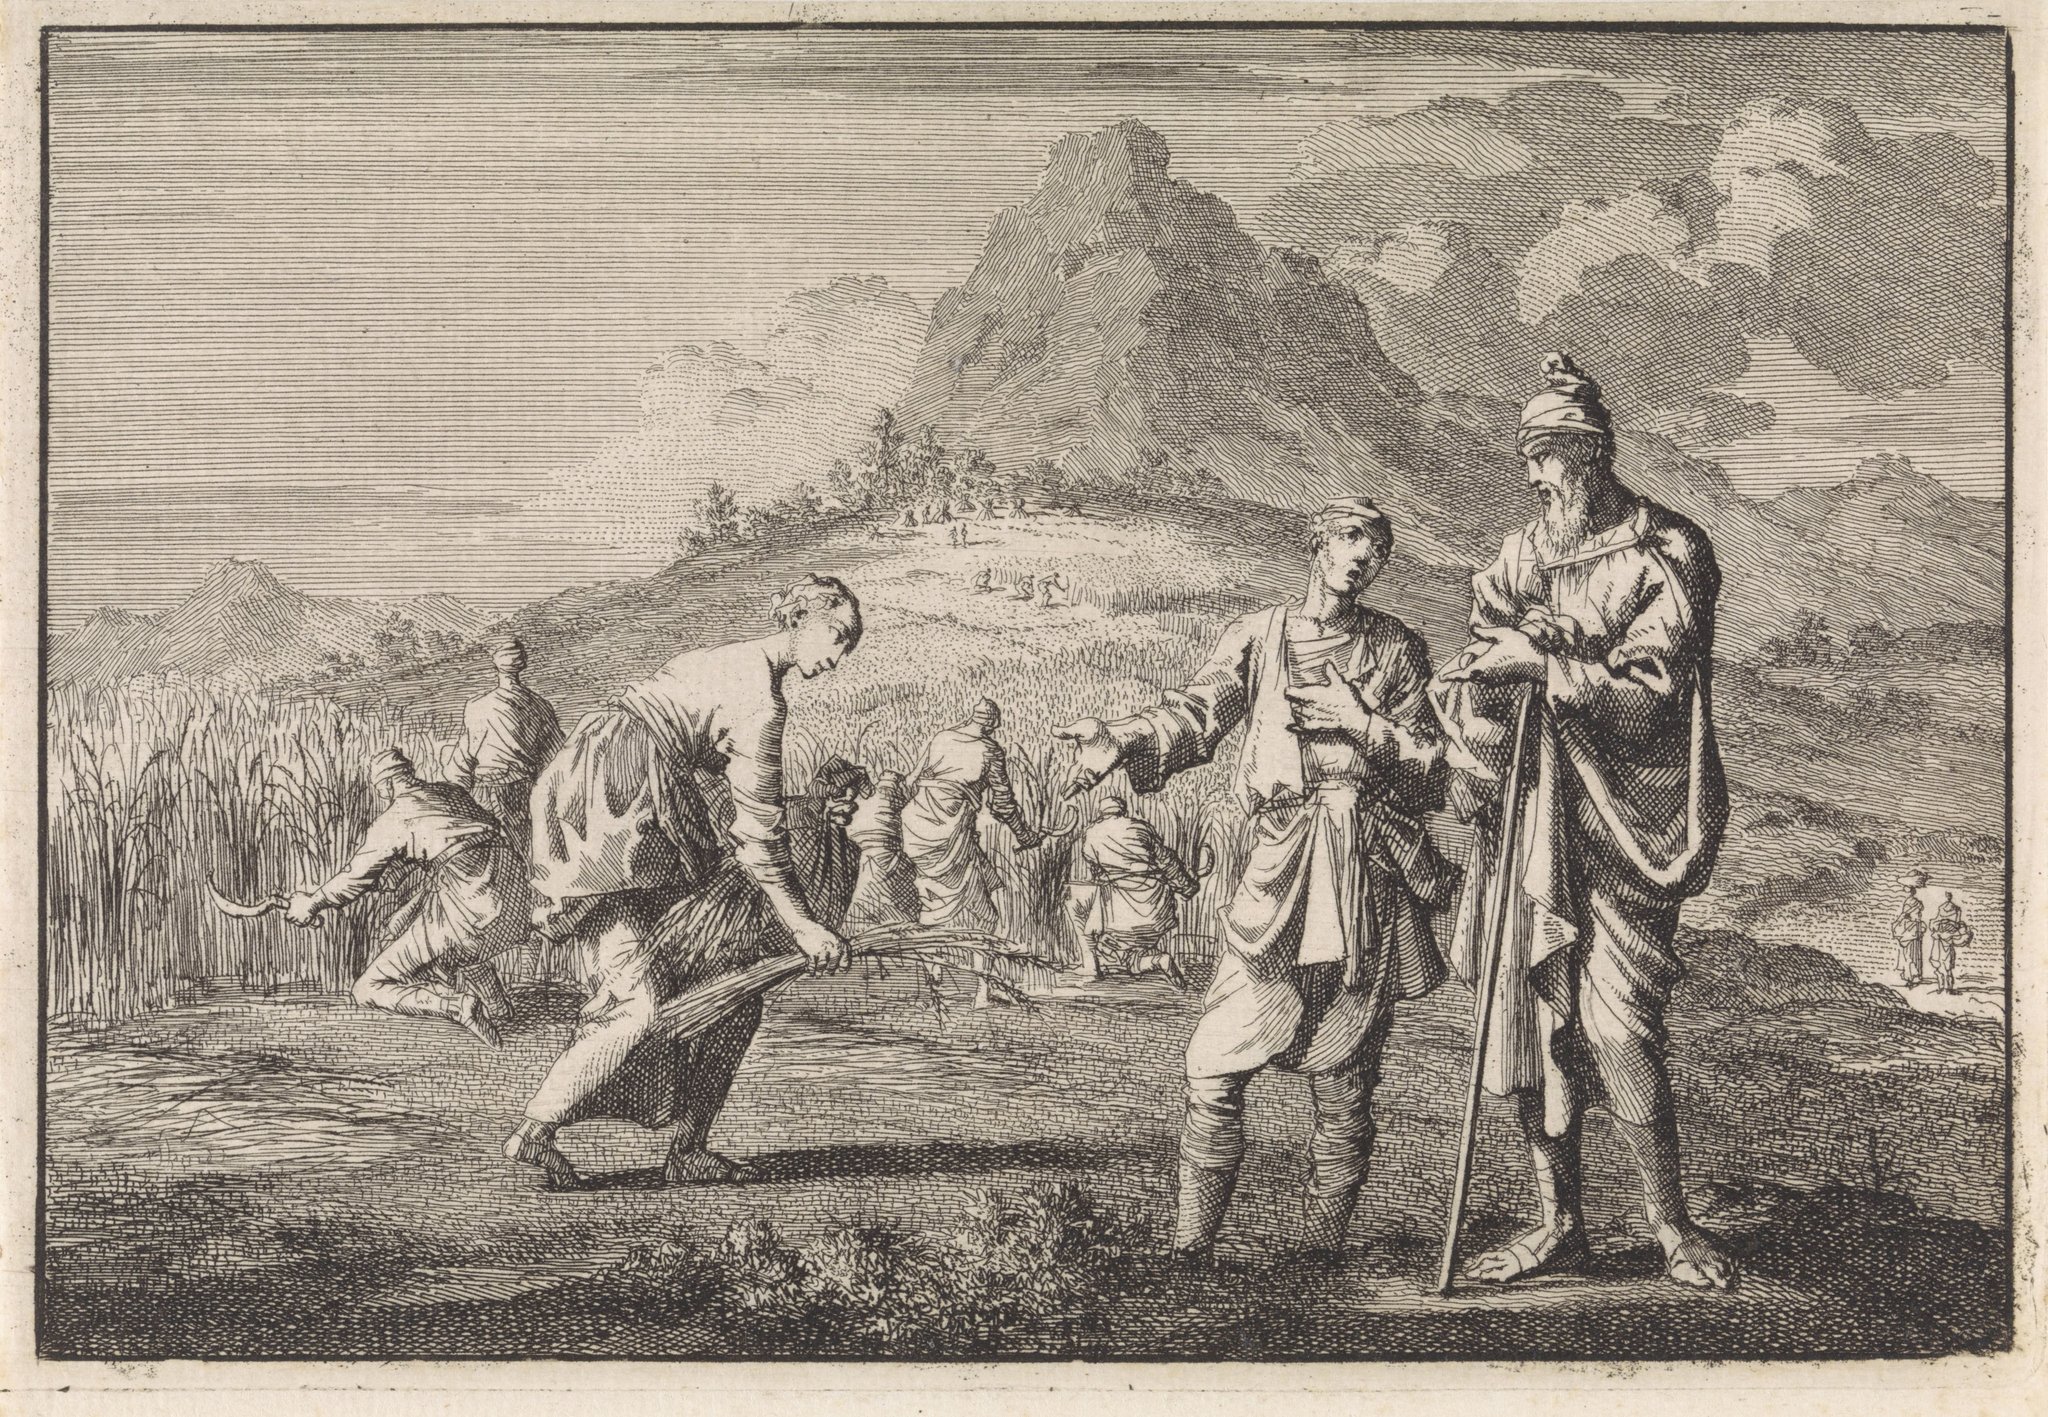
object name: print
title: Boaz ondervraagt zijn opzichter over Ruth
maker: jan luyken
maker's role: draughtsman, print maker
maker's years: 1649-1712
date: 1704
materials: paper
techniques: etching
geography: amsterdam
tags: boaz questions his servant concerning ruth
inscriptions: collector's mark: Lugt 2228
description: Prent ook gebruikt als boekillustratie in: Josephus, Flavius. Alle de Werken, 2 delen. Amsterdam: Pieter Mortier, 1704, dl. 1, p. 124.